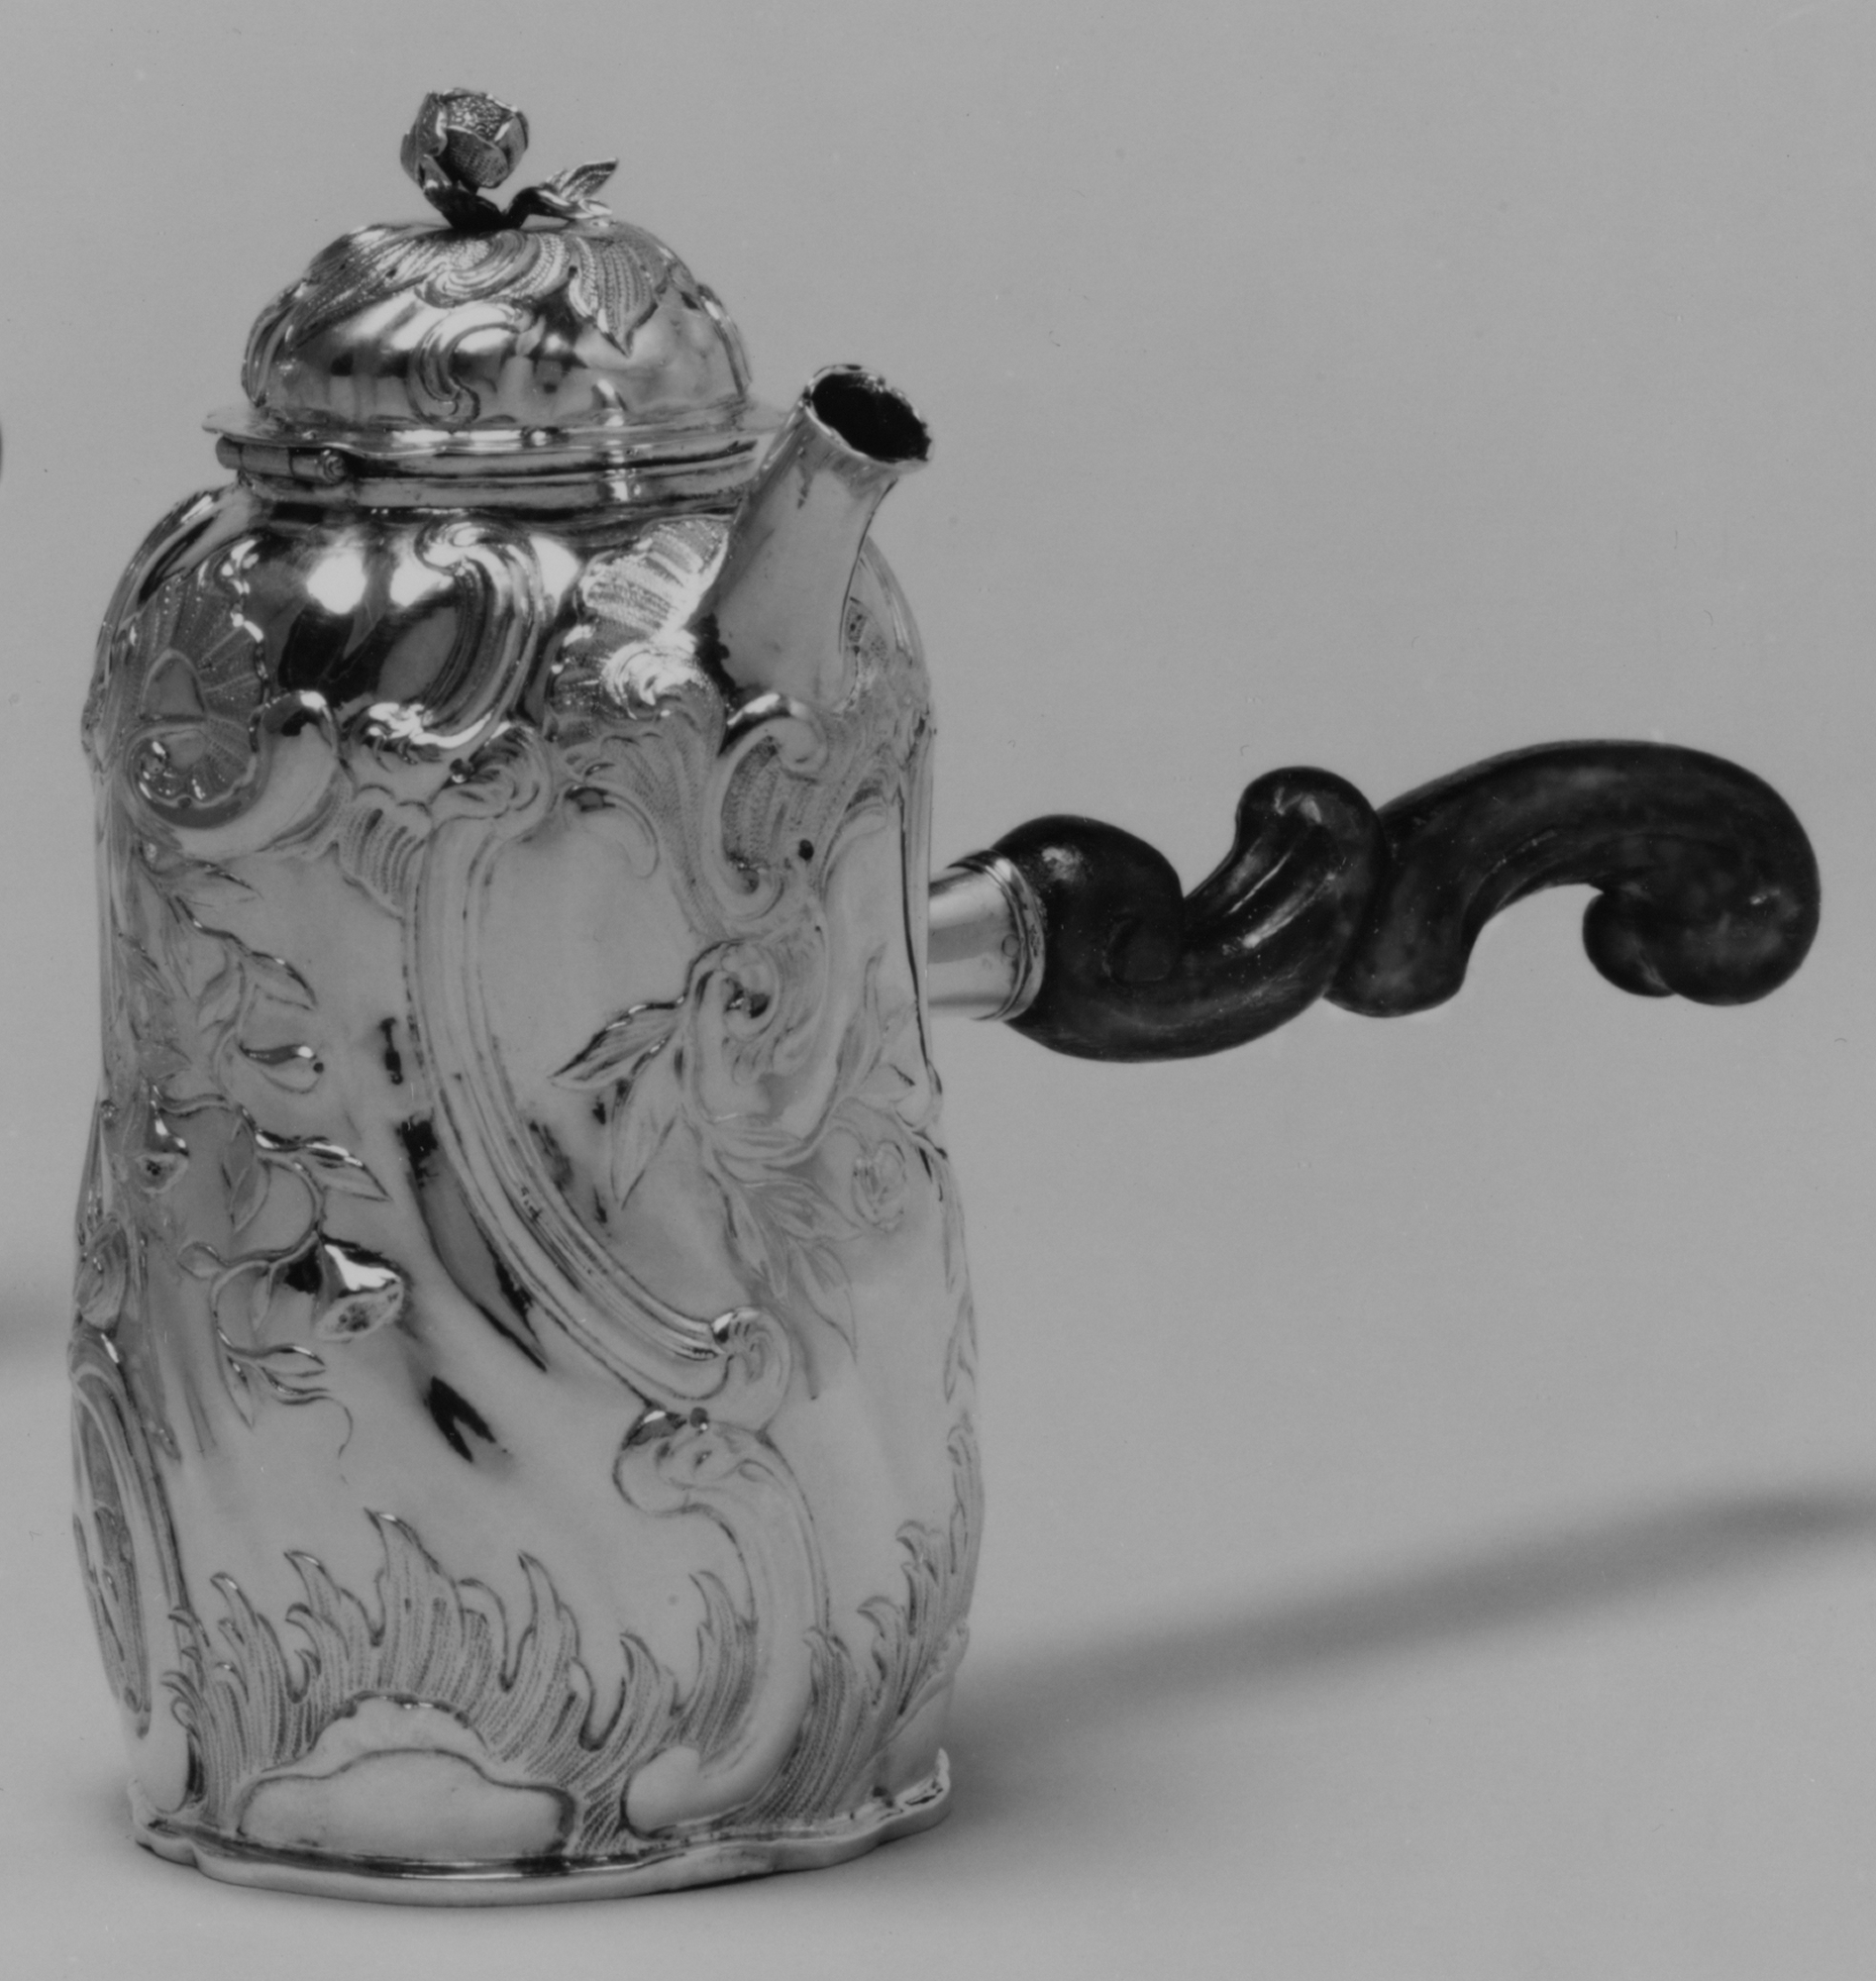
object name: hot milk pot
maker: ernst gottlob borns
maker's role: maker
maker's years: 1730-1782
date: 1765-1770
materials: wood, silver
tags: flowers